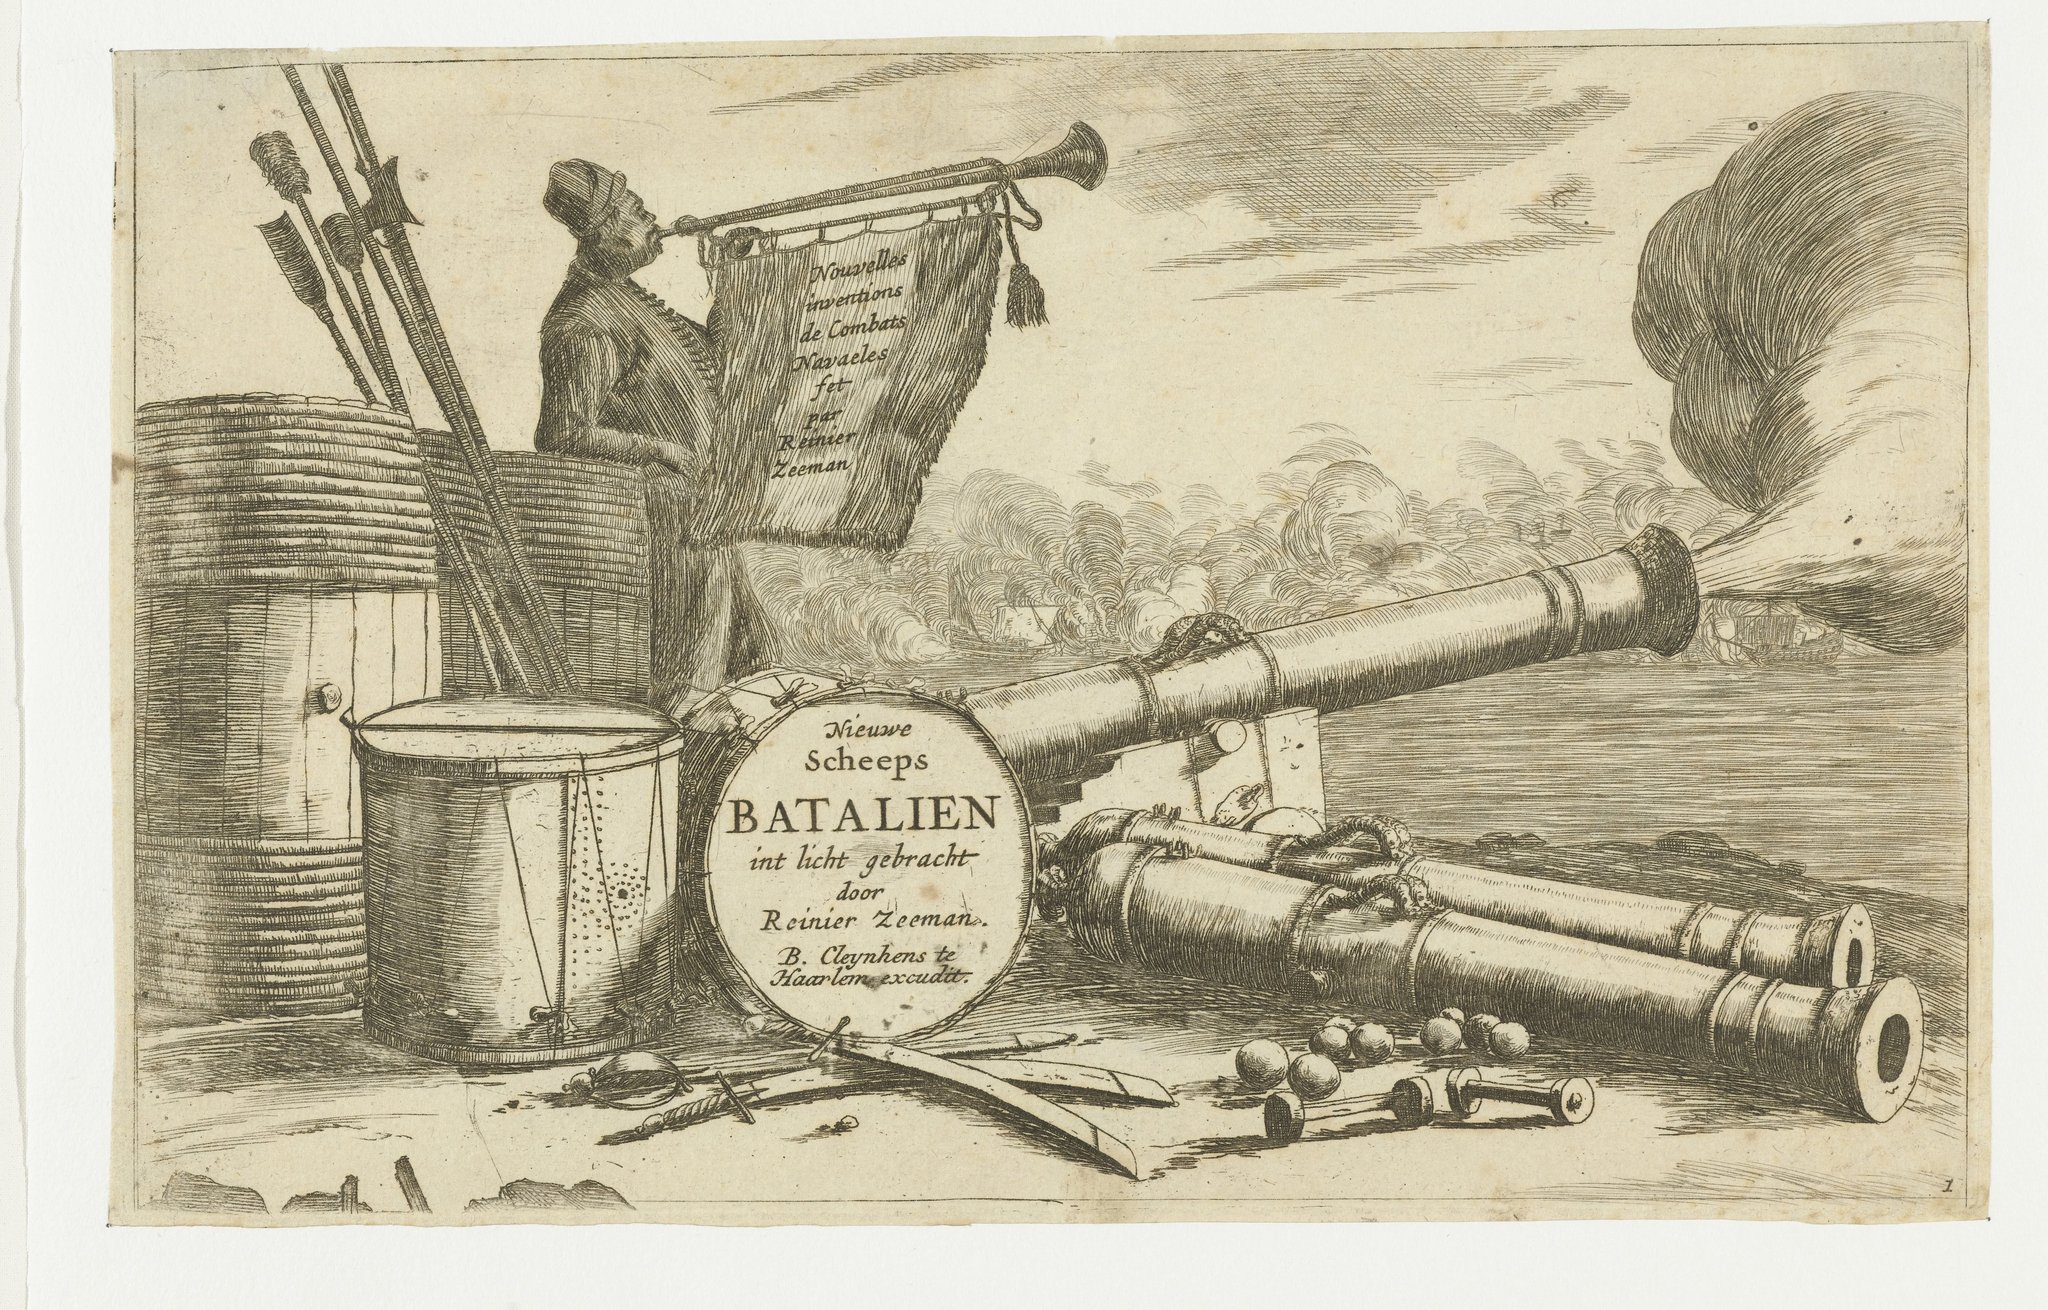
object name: titelprent, frontispice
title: Nieuwe Scheeps Batalien in het licht gebracht door Reinier Zeeman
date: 1652-1656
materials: paper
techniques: drypoint, etching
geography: netherlands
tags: title-page, warfare; military affairs (+ naval force)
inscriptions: collector's mark: Lugt 2228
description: Titelblad voor een reeks van zeeslagen. De uitrusting van een oorlogsschip waaronder kanonnen, kogels, kruitvaten en twee trommels. Een zeeman blaast op een trompet waaraan een vlag hangt.